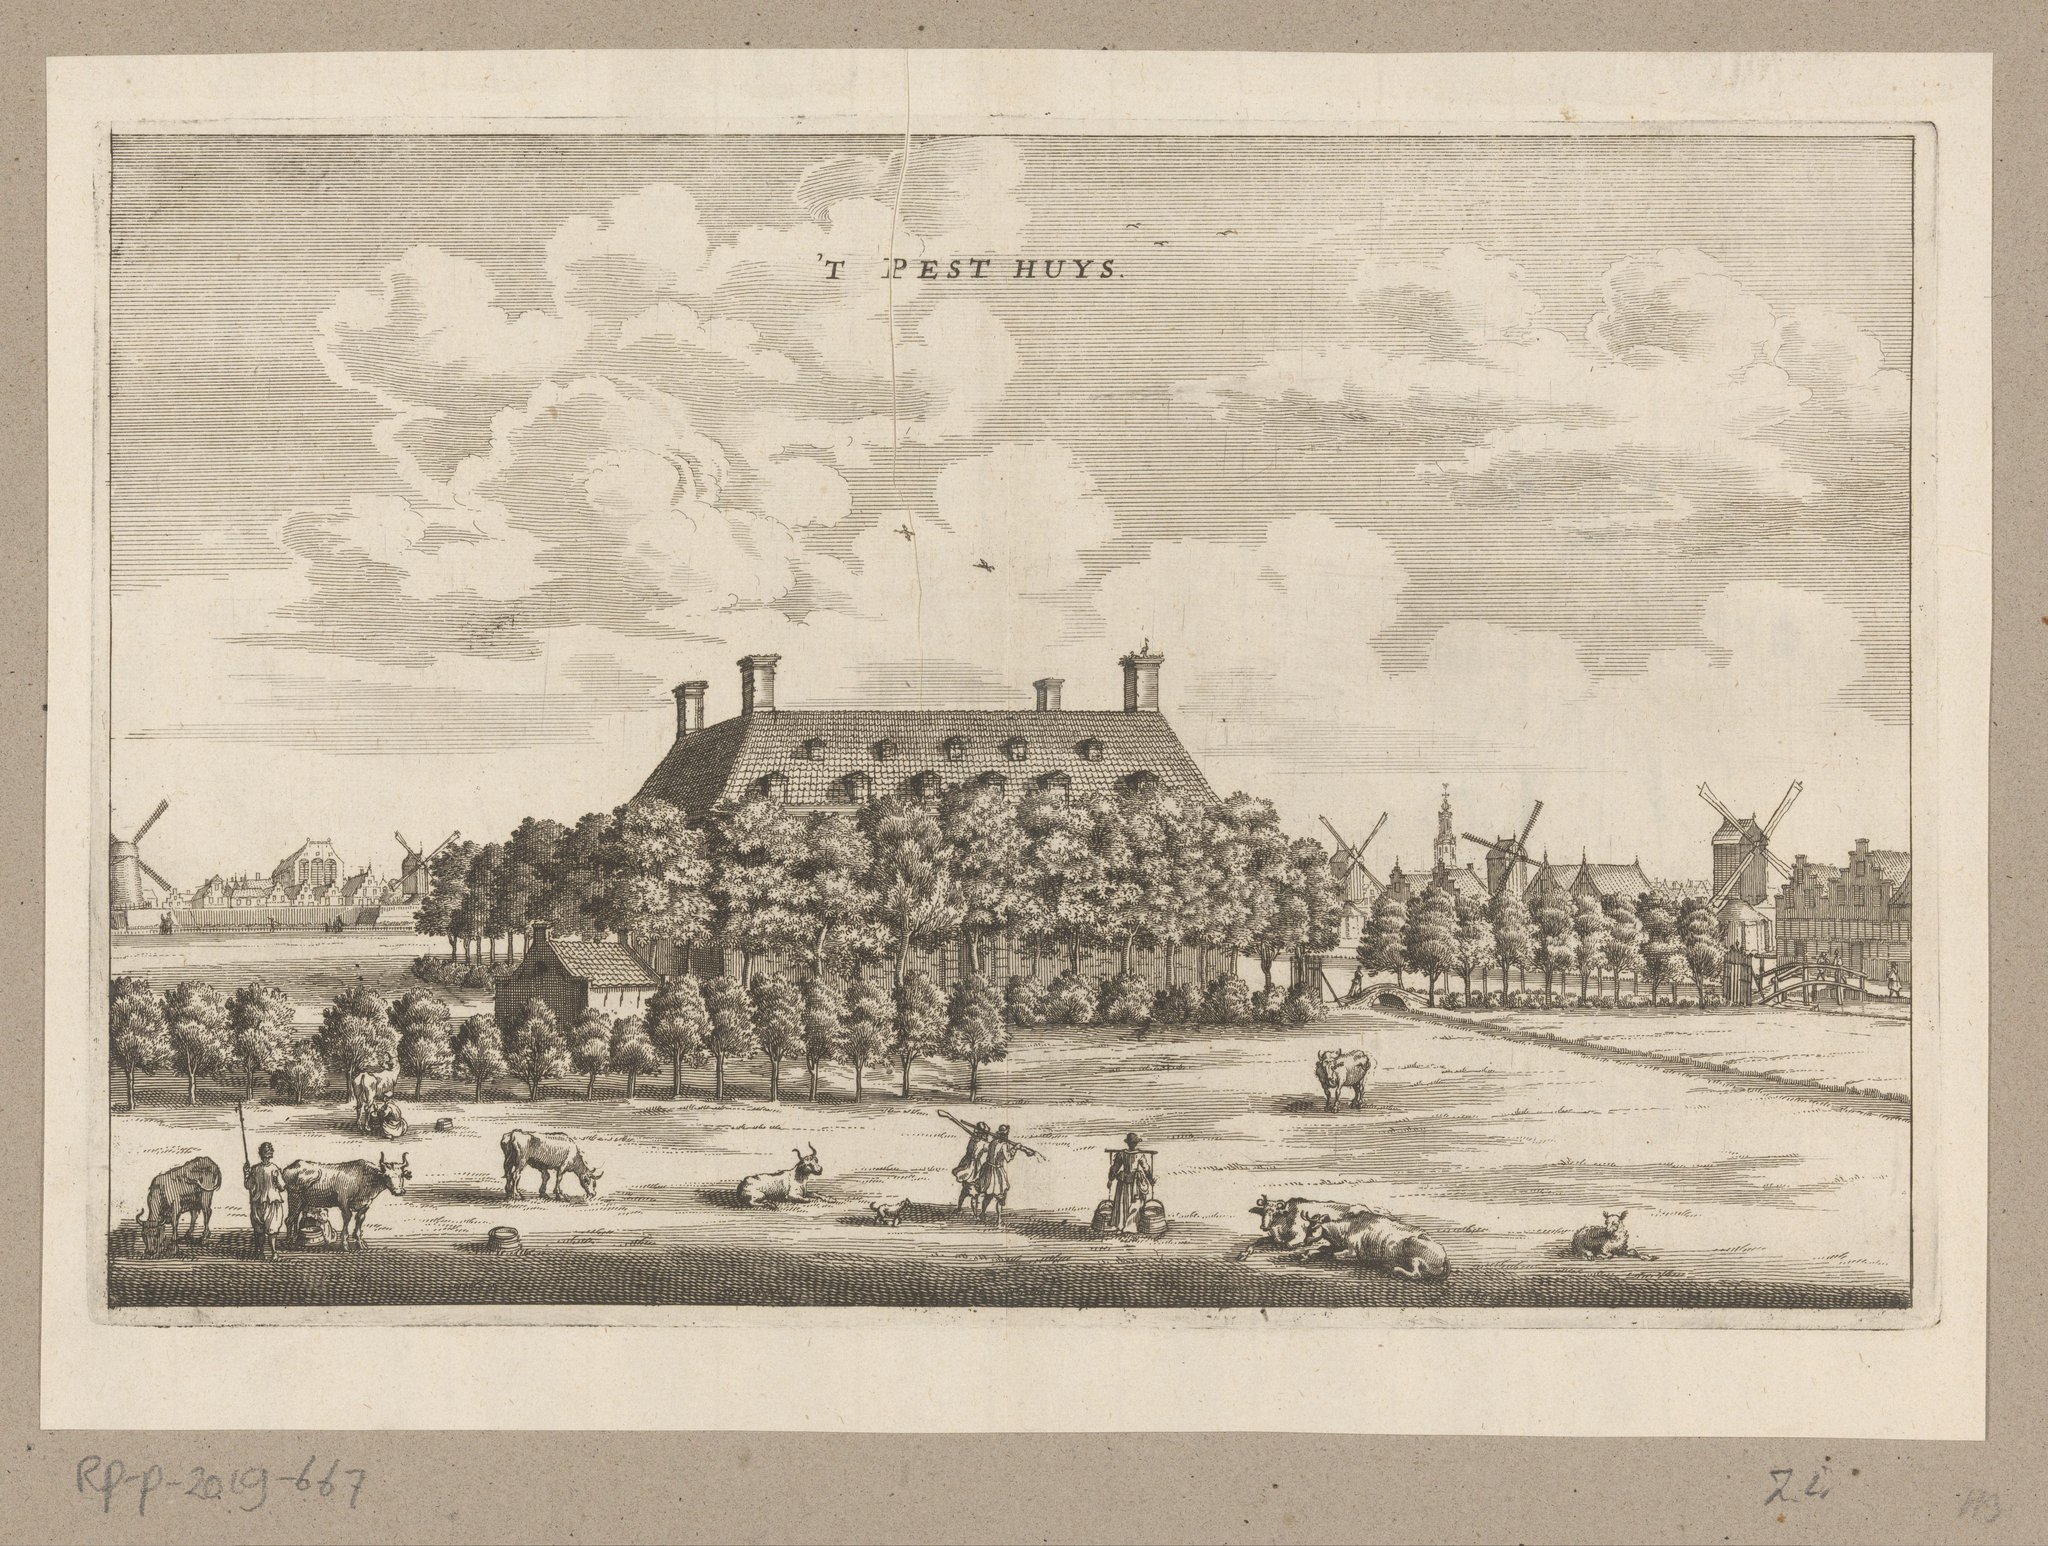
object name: print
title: Gezicht op het Pesthuis (Buitengasthuis) bij Amsterdam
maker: jacob van meurs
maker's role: draughtsman, print maker, publisher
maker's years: 1619-1680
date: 1663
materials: paper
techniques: engraving, etching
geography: amsterdam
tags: public welfare, hospital, prospect of city, town panorama, silhouette of city (+ city(-scape) with figures, staffage)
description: Prent uit: Dapper, Olfert. Historische beschryving der stadt Amsterdam: waer in de voornaemste geschiedenissen (na een kort verhael van gansch Hollant en d'omleggende dorpen (…). Amsterdam: Jacob van Meurs, 1663. De tweede staat van de prent heeft een toegevoegde Franse titel.